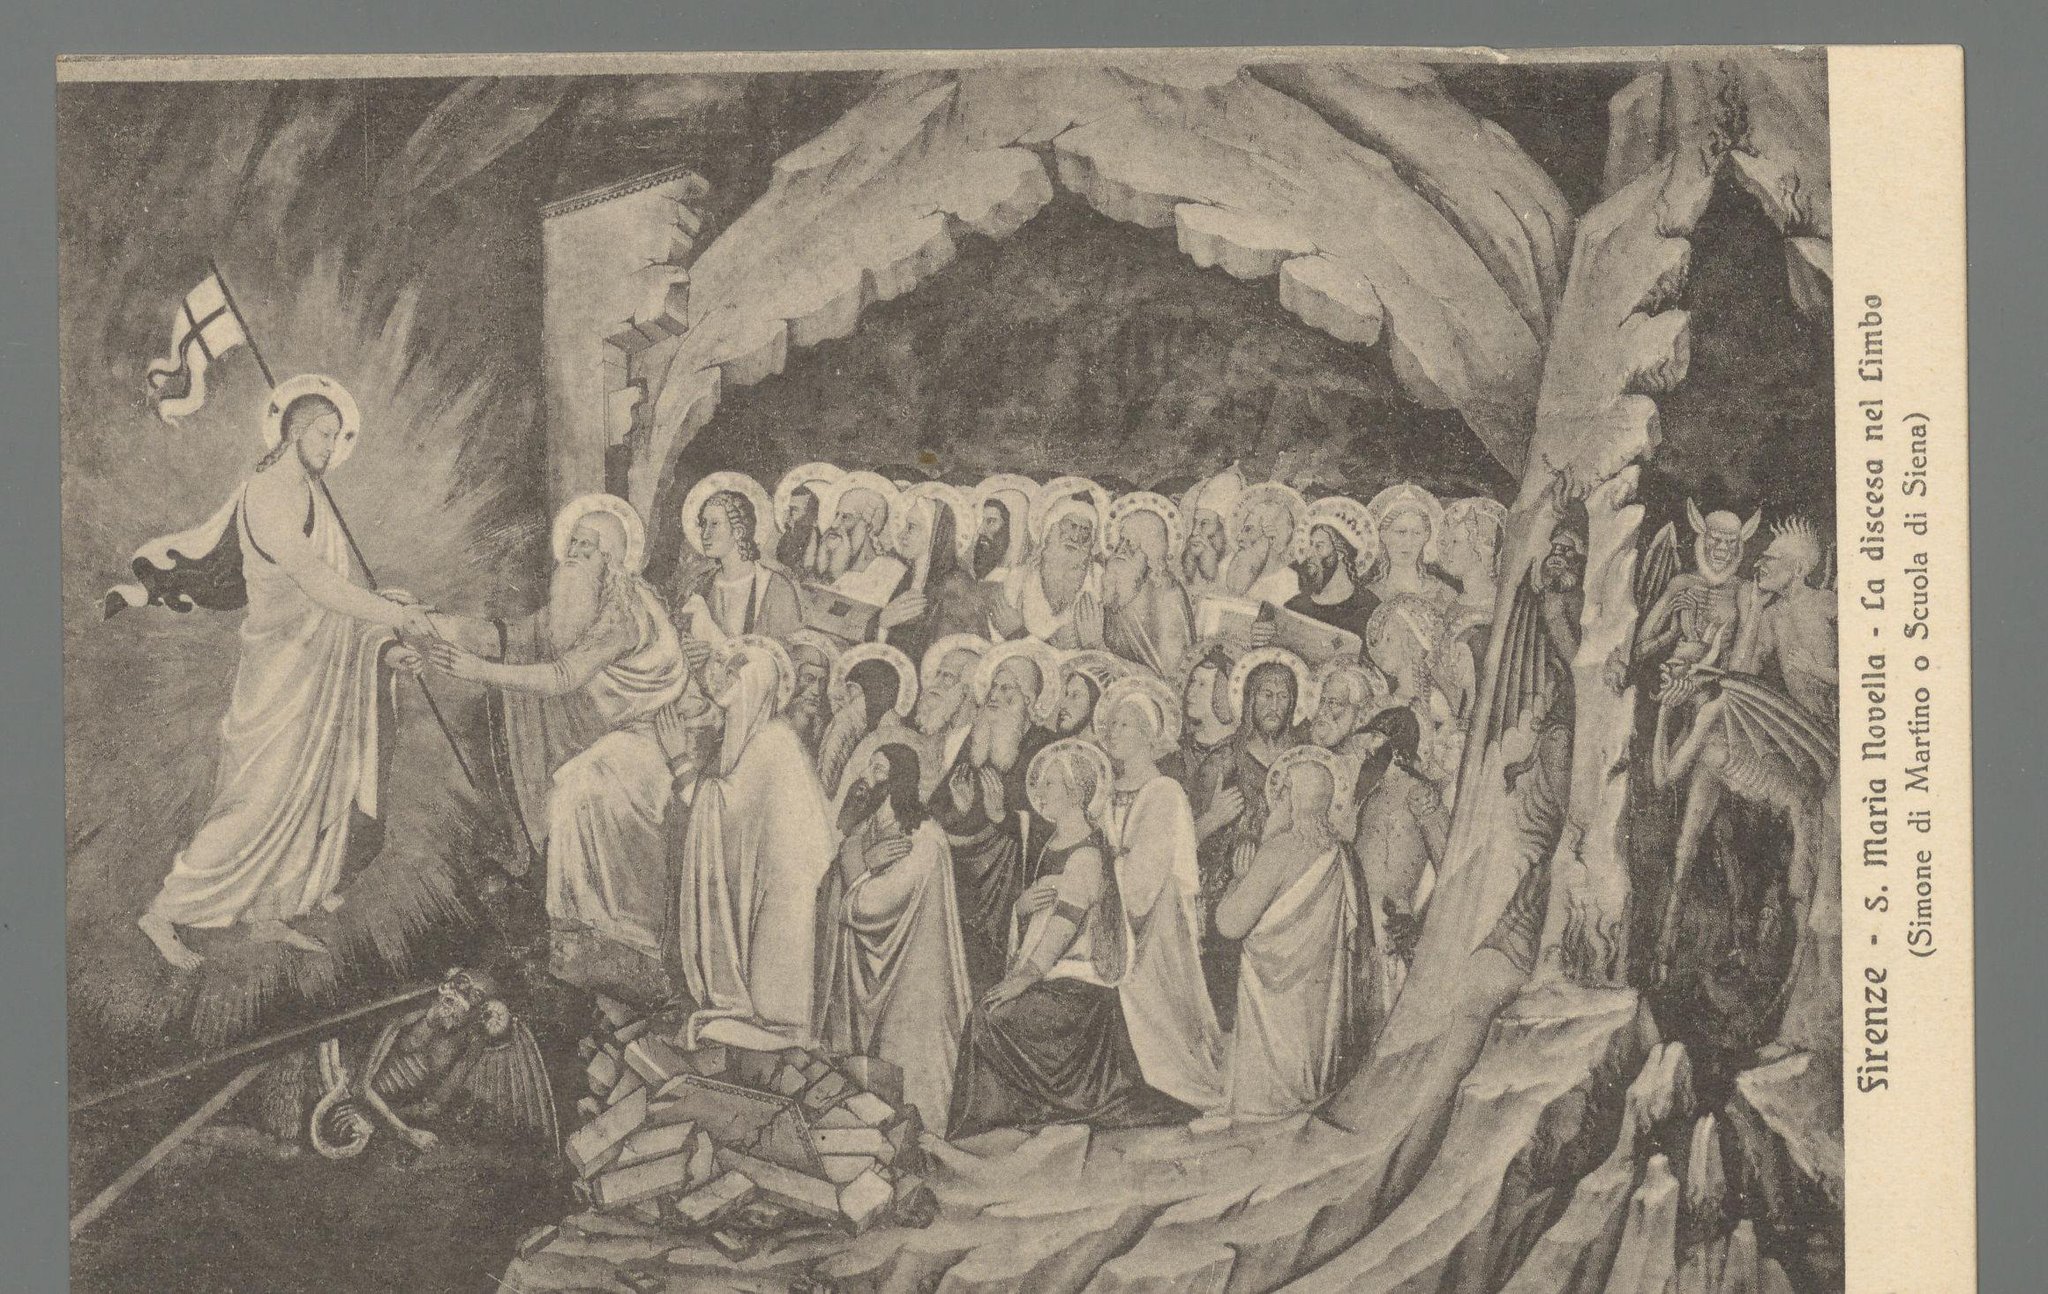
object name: reproduction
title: Firenze - S. Maria Novella. La discesa nel Limbo (Simone di Martino o Scuola di Siena)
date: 1906-1930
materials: cardboard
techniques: photograph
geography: florence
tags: church (exterior), picture, painting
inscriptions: inscription: ‘Edit. A. O. - Firenze’, collector's mark: ‘AFE v S’